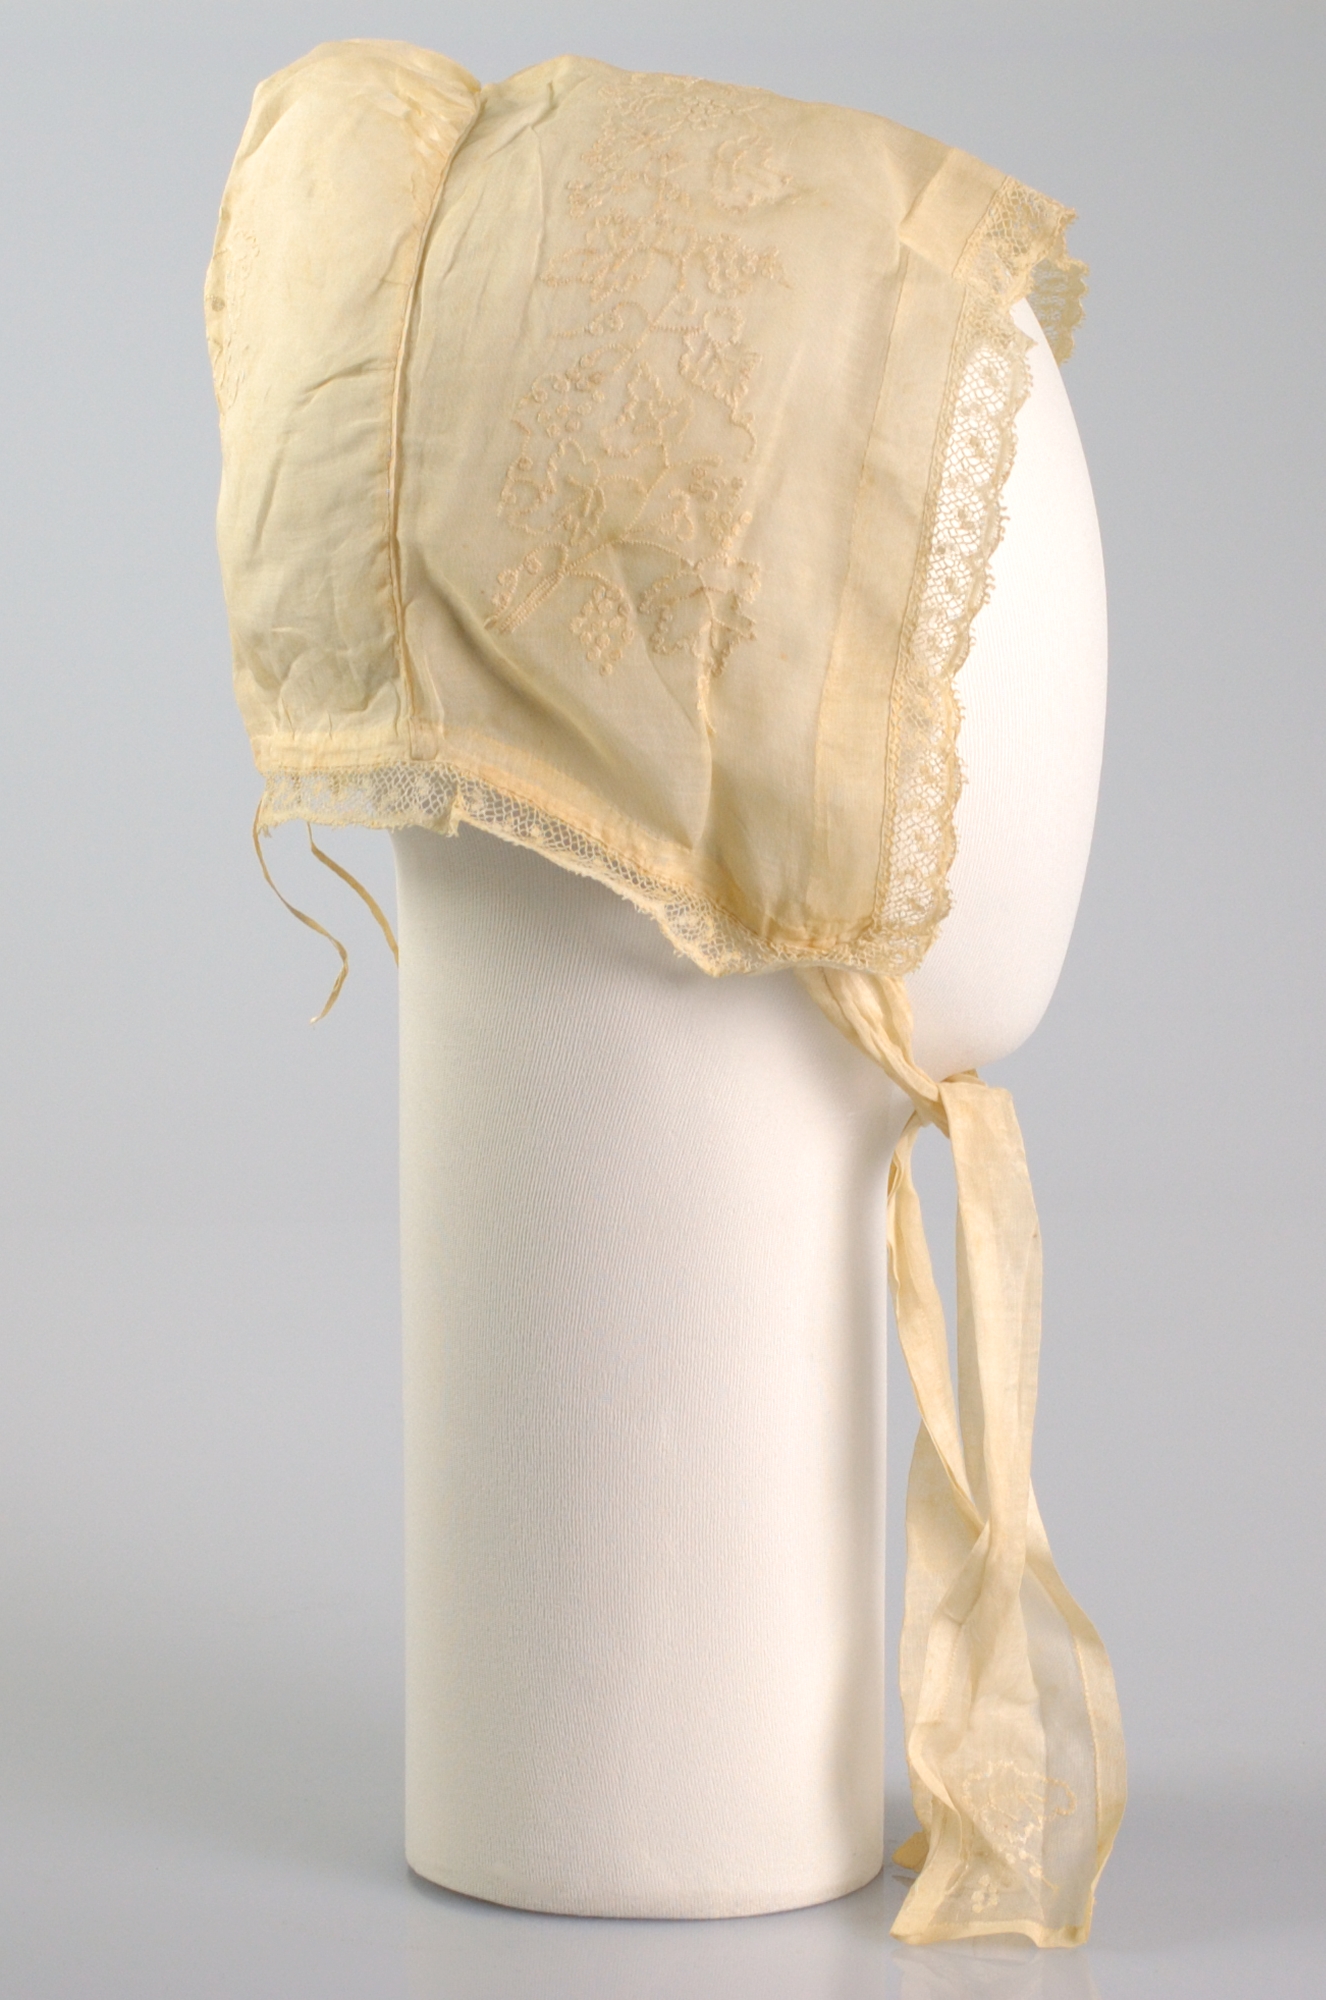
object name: cap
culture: american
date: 1850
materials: cotton, linen